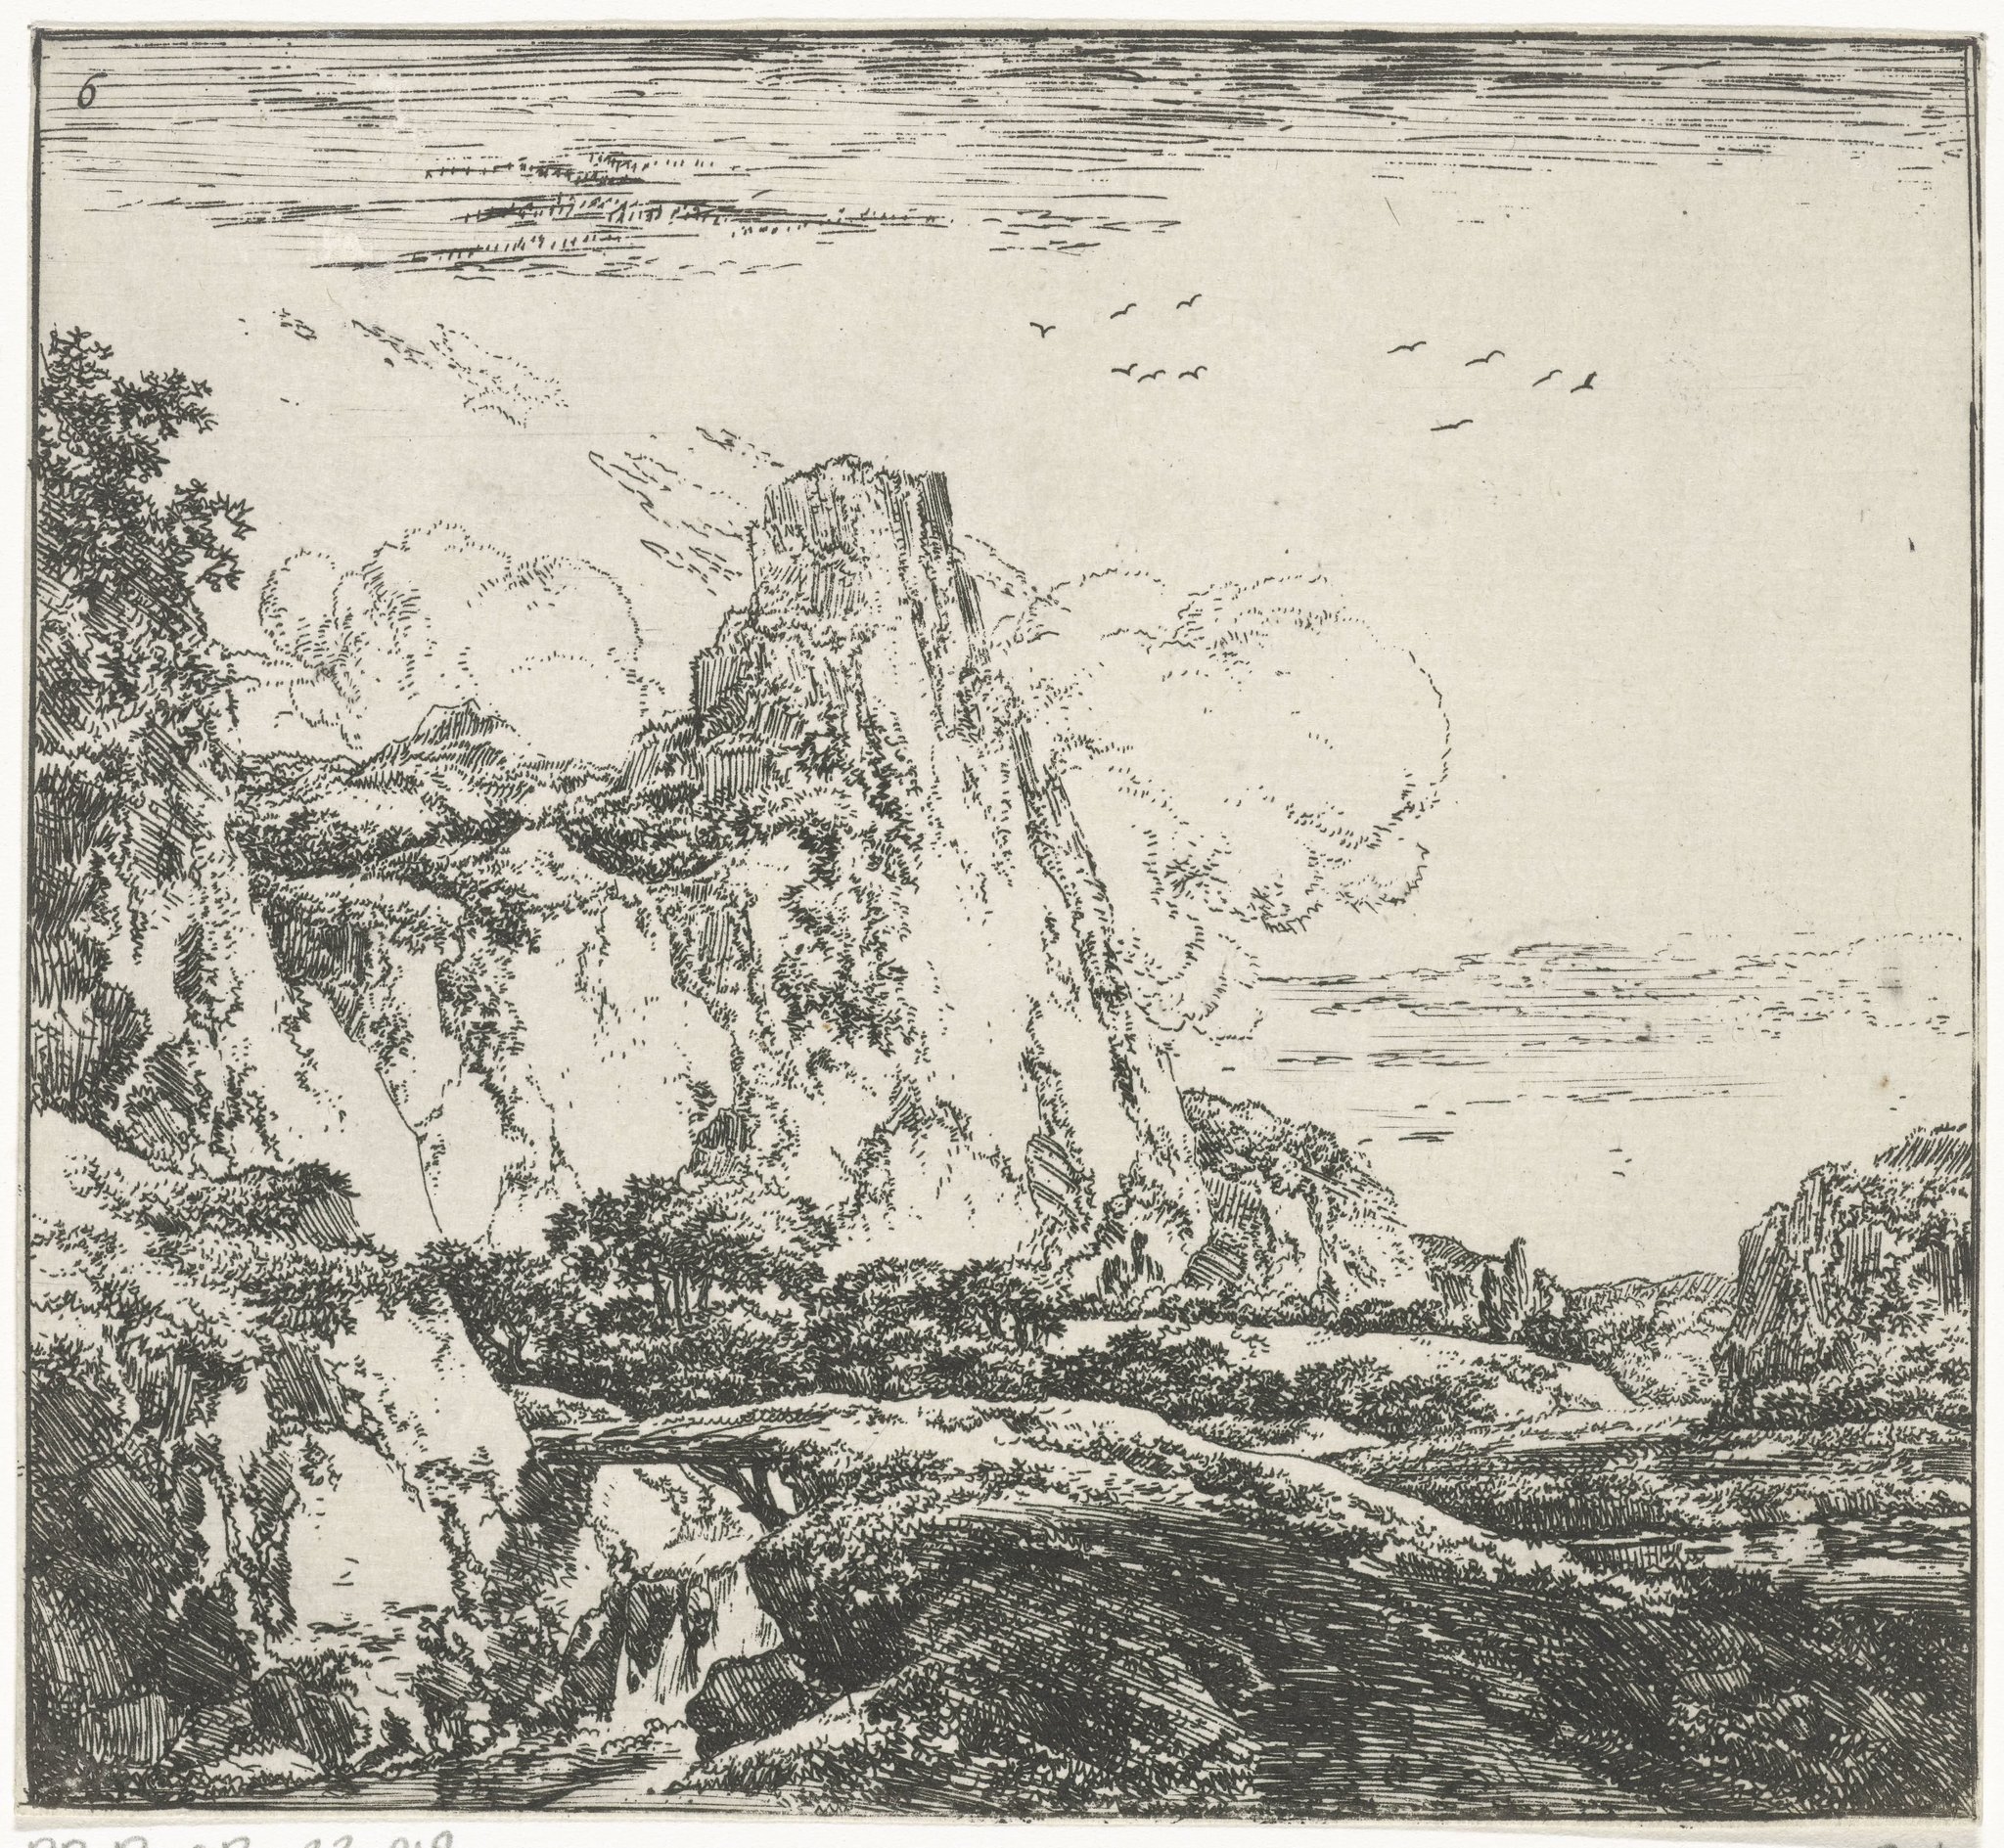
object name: print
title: Serie 1: Landschappen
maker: herman naiwincx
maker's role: draughtsman, print maker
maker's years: 1623-1670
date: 1633-1670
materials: paper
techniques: etching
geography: amsterdam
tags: bridge, mountains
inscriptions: collector's mark: Lugt 240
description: Een brug over een waterval, links bergen.